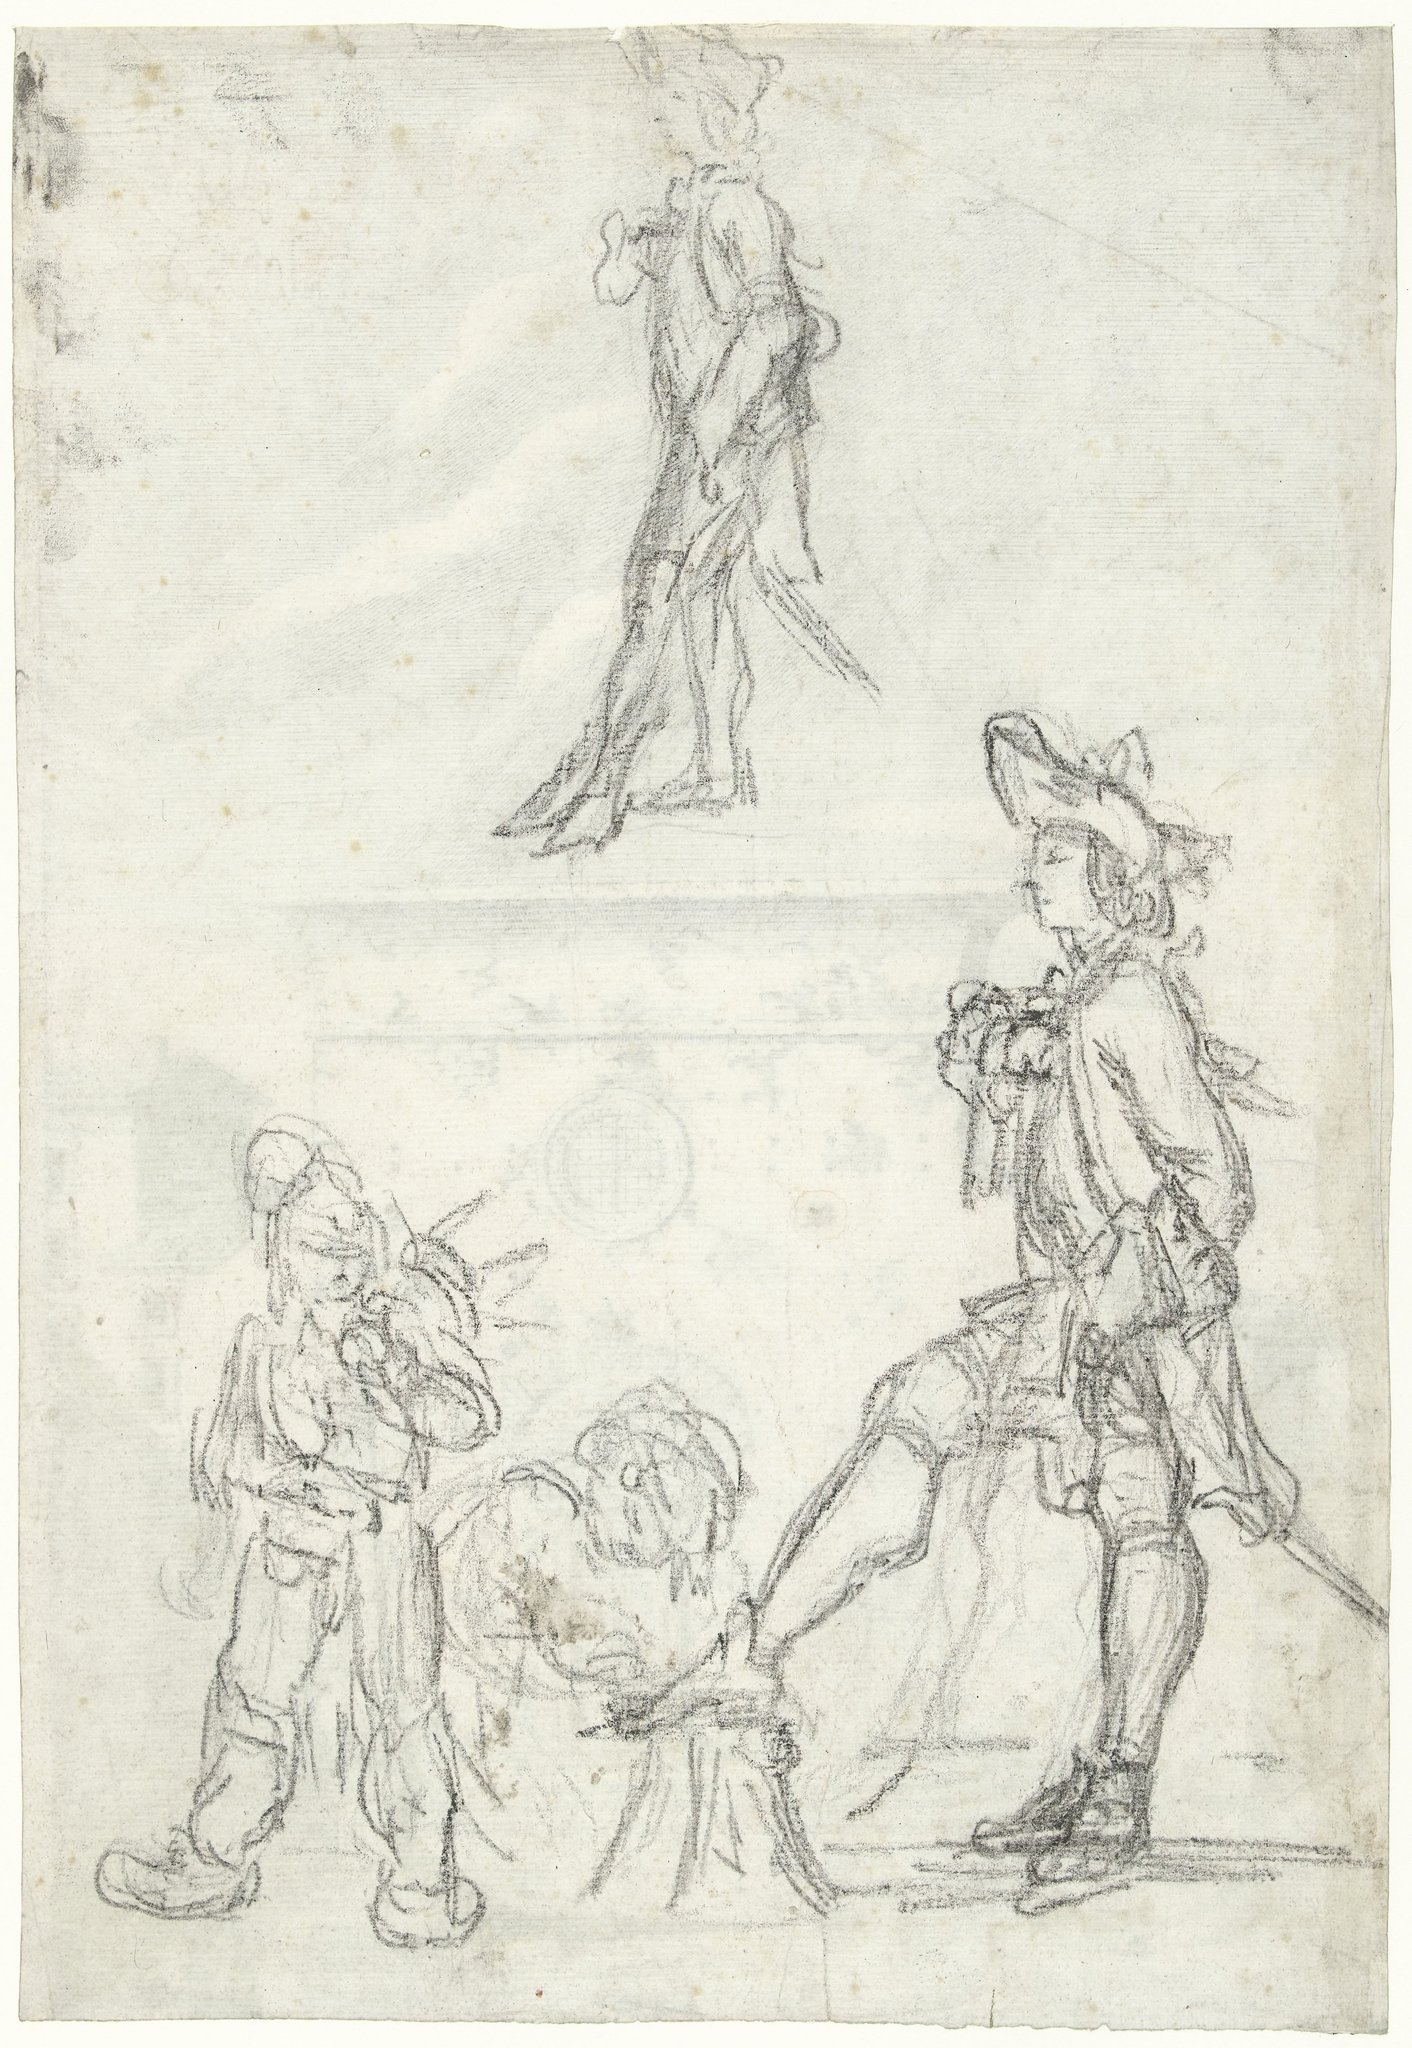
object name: drawing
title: Jongeman laat zijn schoenen poetsen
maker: Anonymous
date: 1740-1760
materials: chalk, paper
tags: shoes, sandals (+ men's clothes)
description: Een jongeman met een steek en degen laat zijn schoenen poetsen; naast de poetser een staand kind, erboven een herhaling van de figuur van de edelman.